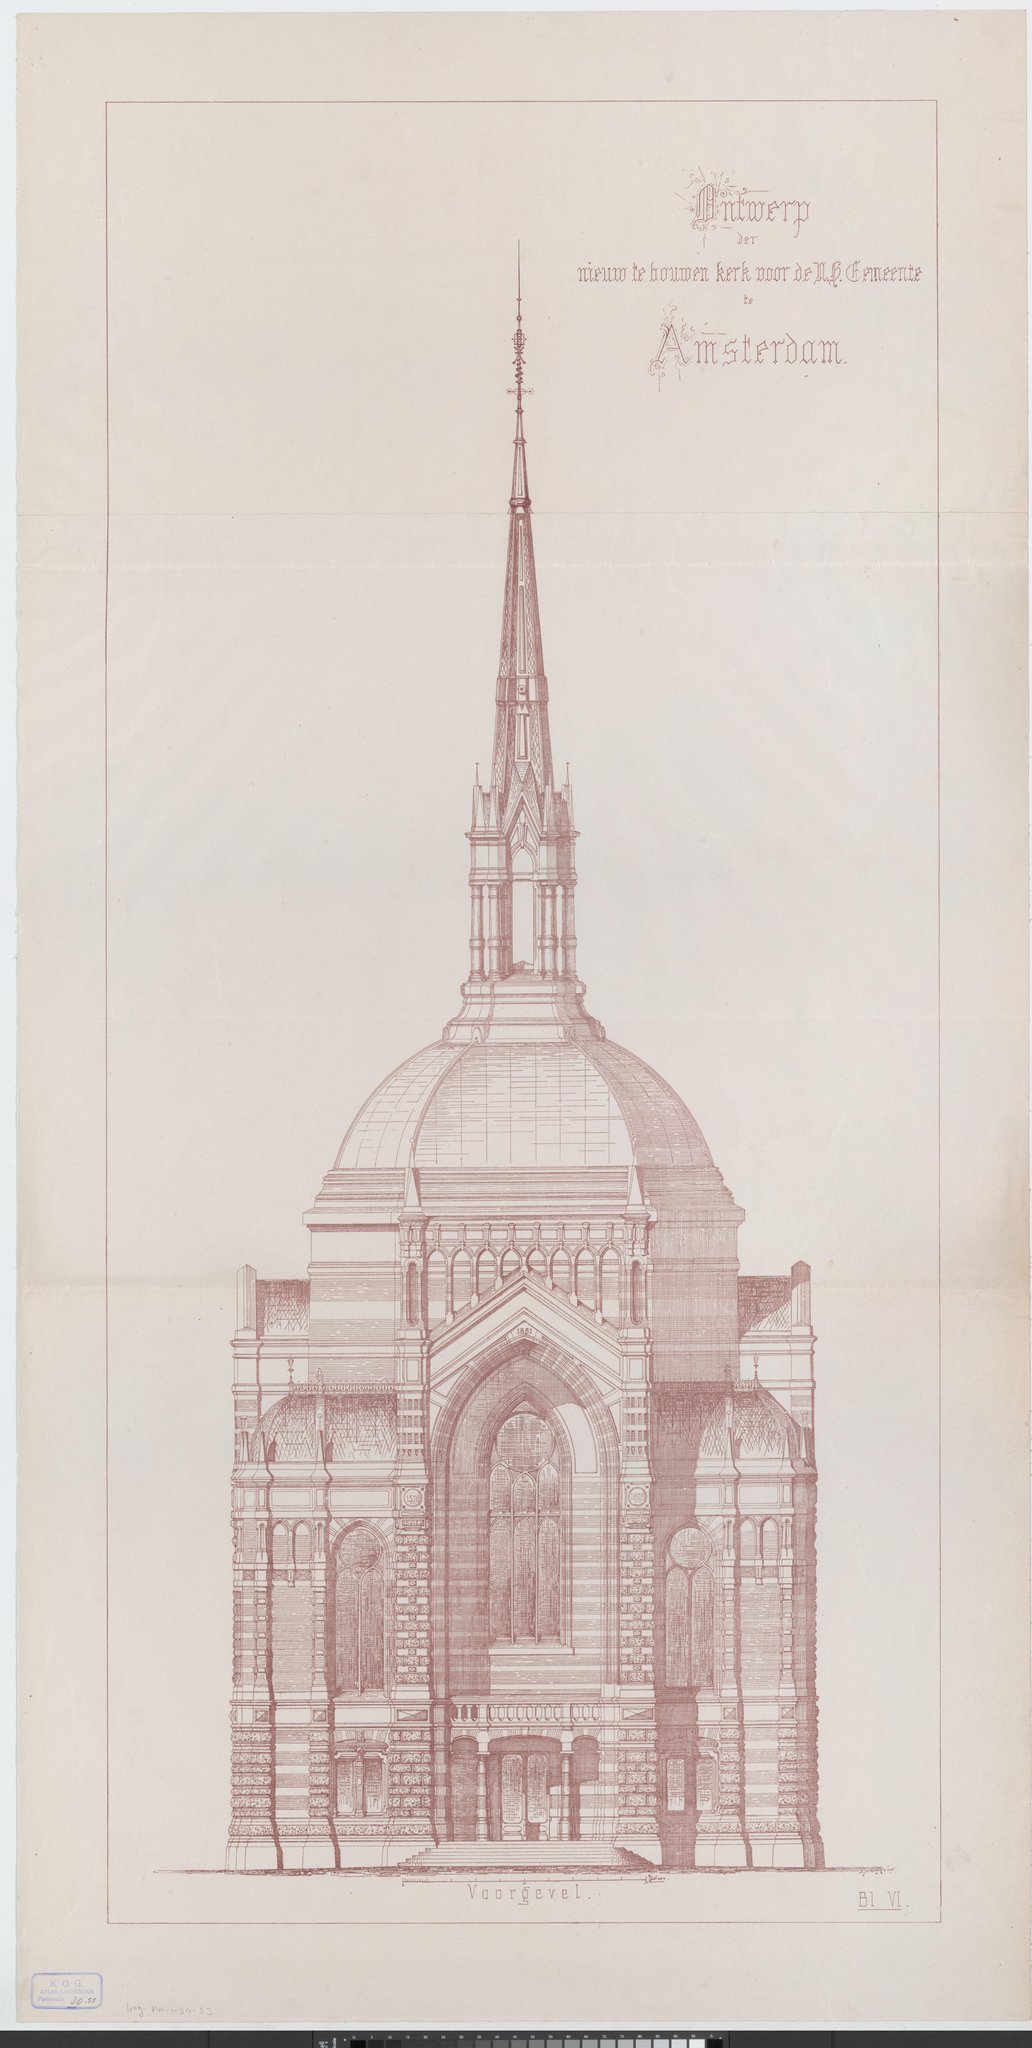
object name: print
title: Ontwerp der nieuw te bouwen kerk voor de N.H. Gemeente te Amsterdam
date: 1881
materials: paper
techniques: lithograph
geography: netherlands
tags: floor plan ~ architectural design or model, building of church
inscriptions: collector's mark: Lugt 1641b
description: Rechtsonder: Bl. VI. Onderwerpsrubriek binnen de Atlas Amsterdam: Kerkwezen: Hervormde Gemeente: Koepelkerk (Leidsebosje).